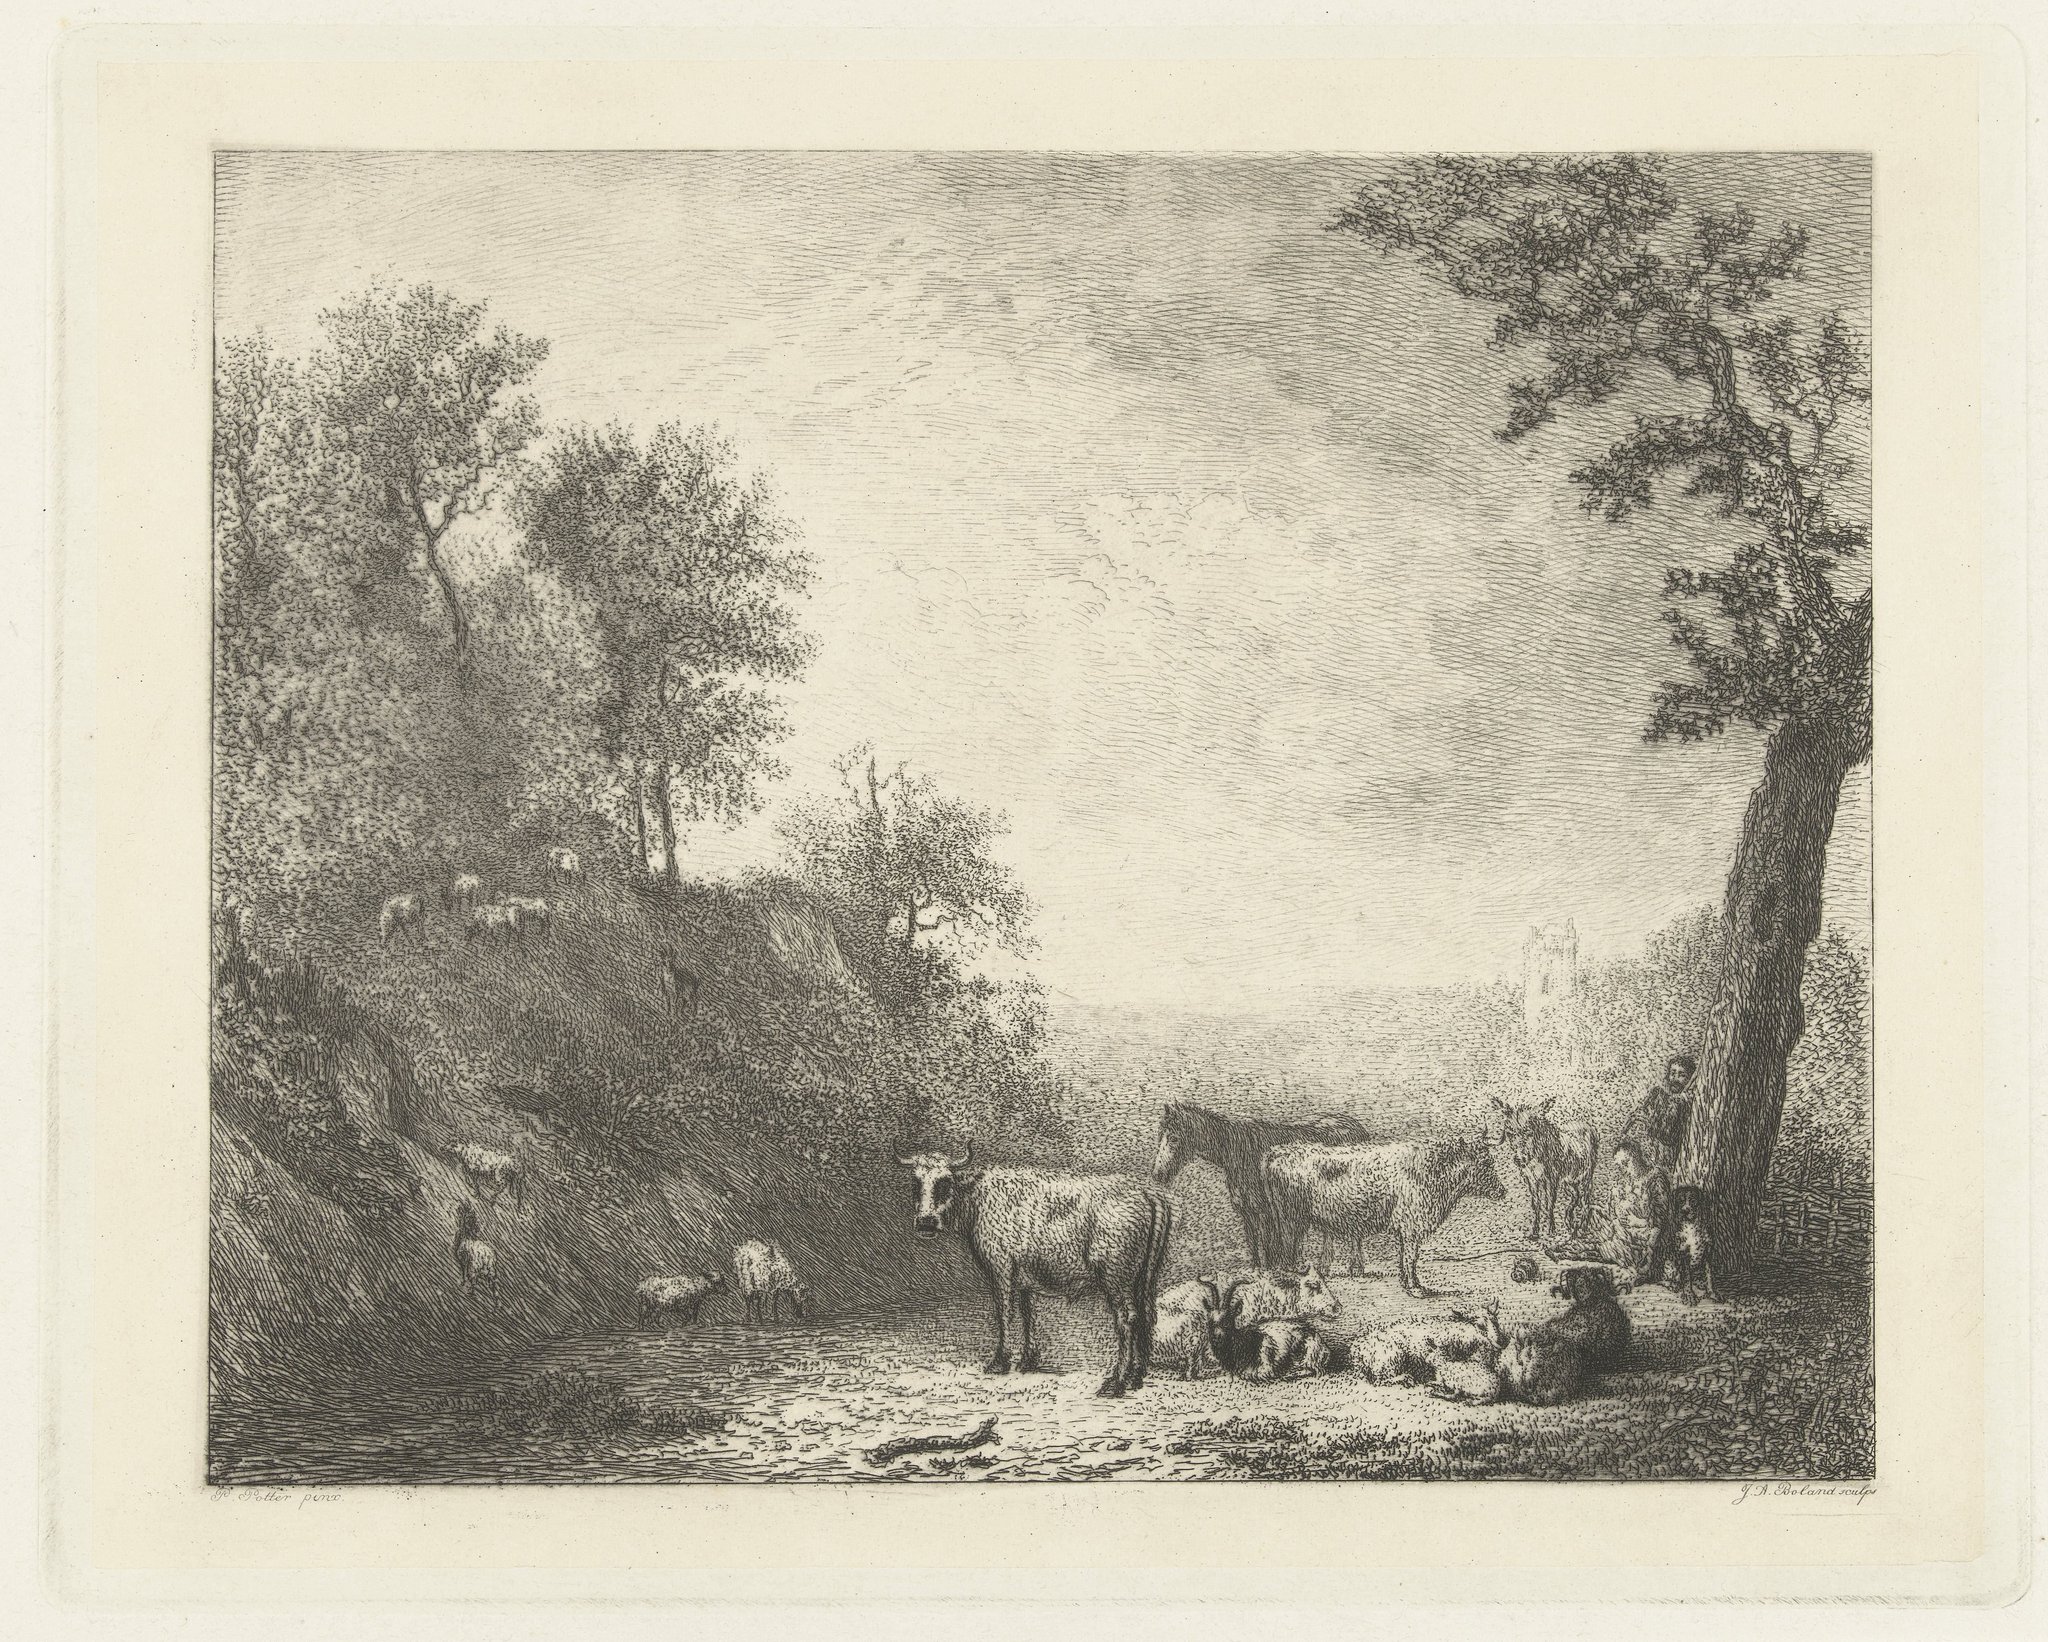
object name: print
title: Herders met hun vee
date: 1875-1876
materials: paper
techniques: etching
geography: amsterdam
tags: herding, herdsman, herdswoman, shepherd, shepherdess, cowherd, etc.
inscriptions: collector's mark: Lugt 2228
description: Reproductie van een schilderij uit de collectie van het Rijksmuseum Amsterdam, SK-A-318. Prent afkomstig uit: Brink, J. ten (et al.). Het Rijksmuseum te Amsterdam: [25] etsen van J.A. Boland. Haarlem: J.M. Schalekamp, [1875-1876] (13 A 20).